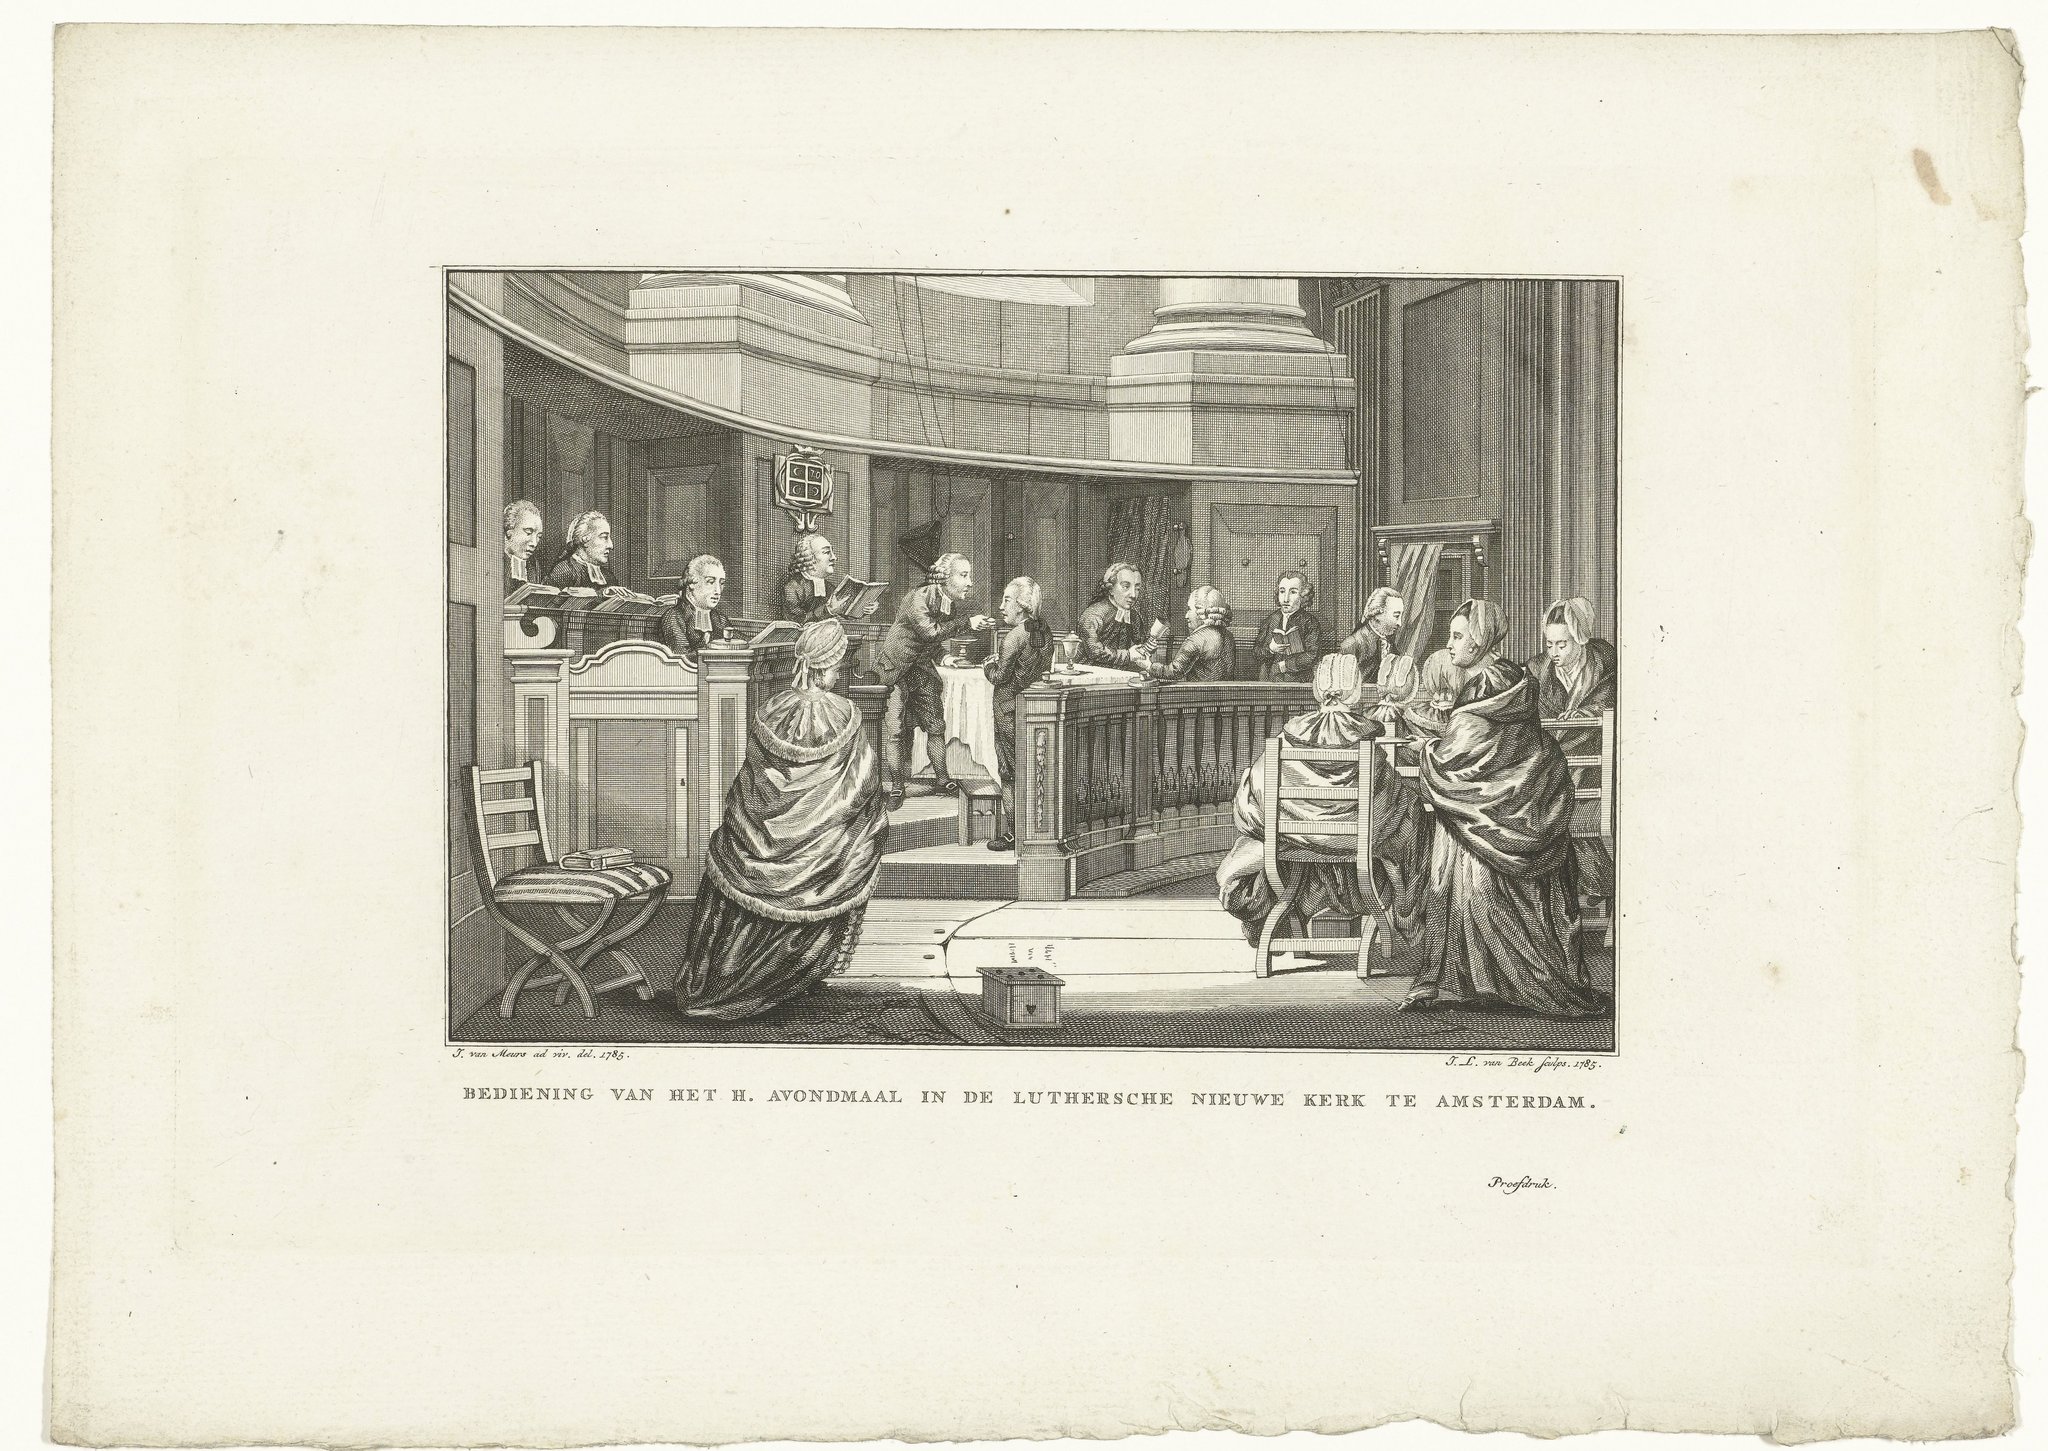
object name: print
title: Godsdiensten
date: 1785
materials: paper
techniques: etching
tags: public worship and liturgy of the christian churches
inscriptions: collector's mark: Lugt 2228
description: Prent uit serie met onbekend aantal prenten van Godsdiensten. Prent naar tekening van Jacobus Meurs.